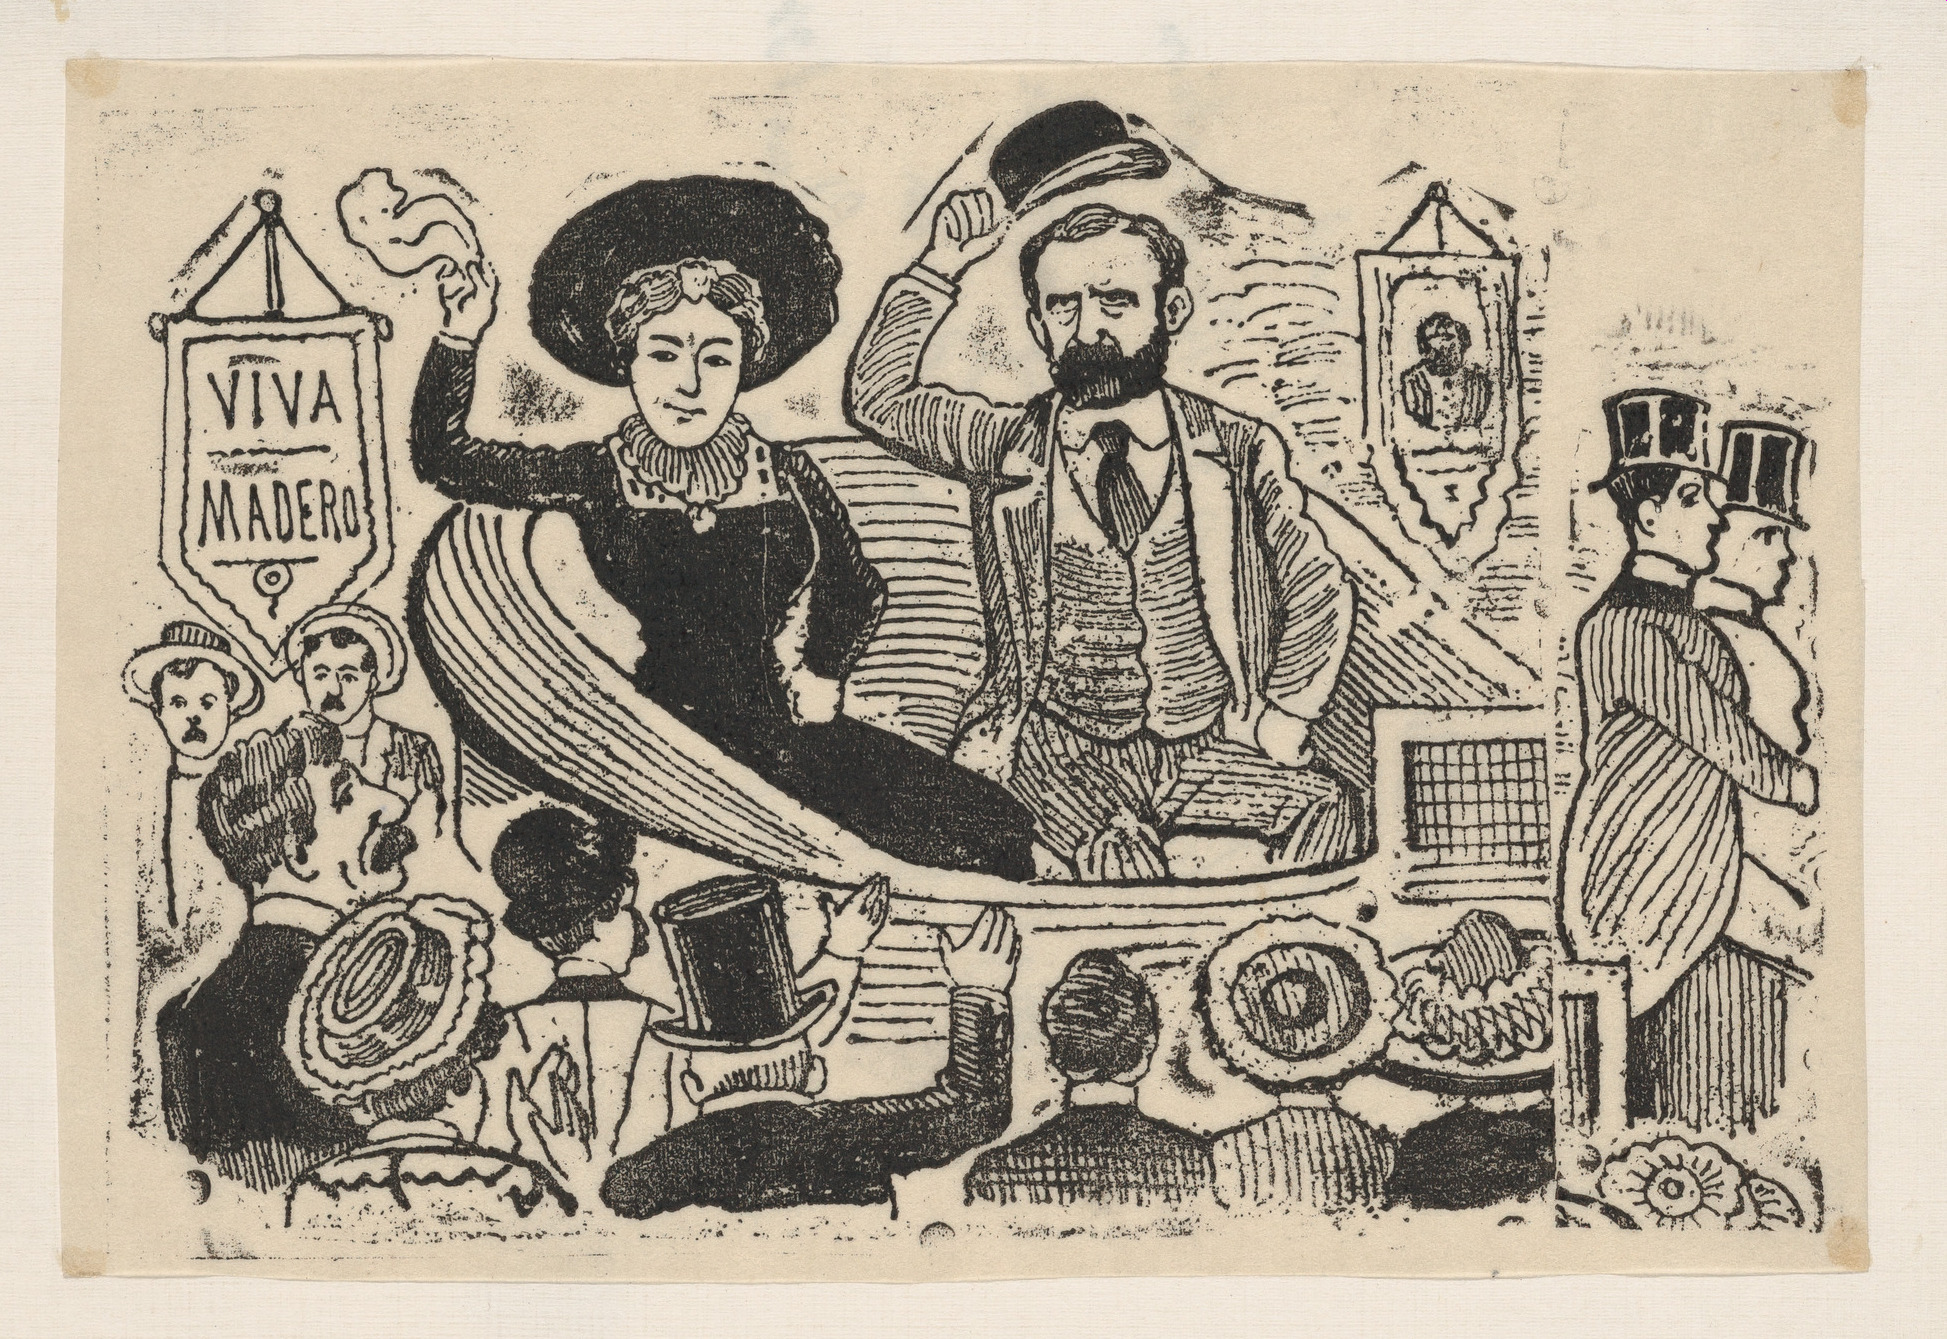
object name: print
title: President Madero and his wife entering Mexico City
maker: josé guadalupe posada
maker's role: artist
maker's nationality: mexican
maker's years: 1852-1913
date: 1911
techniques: lithography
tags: men,women